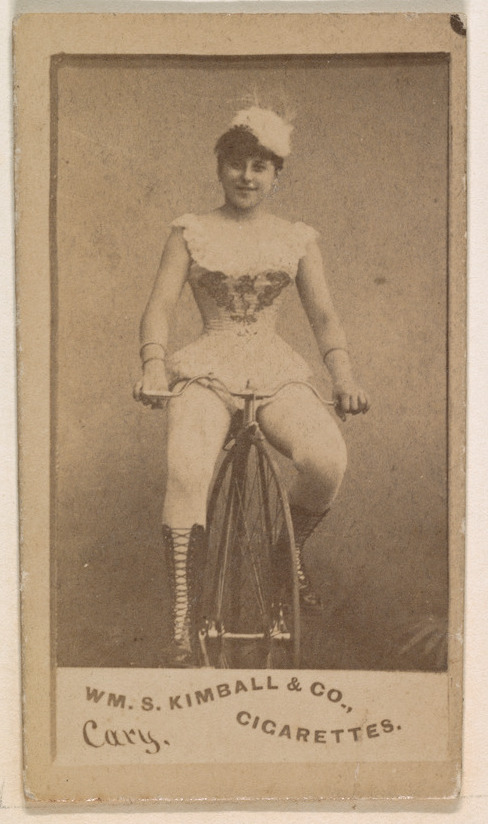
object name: photograph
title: Miss Cary, from the Actresses series (N203) issued by Wm. S. Kimball & Co.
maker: william s. kimball & company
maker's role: publisher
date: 1889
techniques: color lithograph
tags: portraits,women,actresses